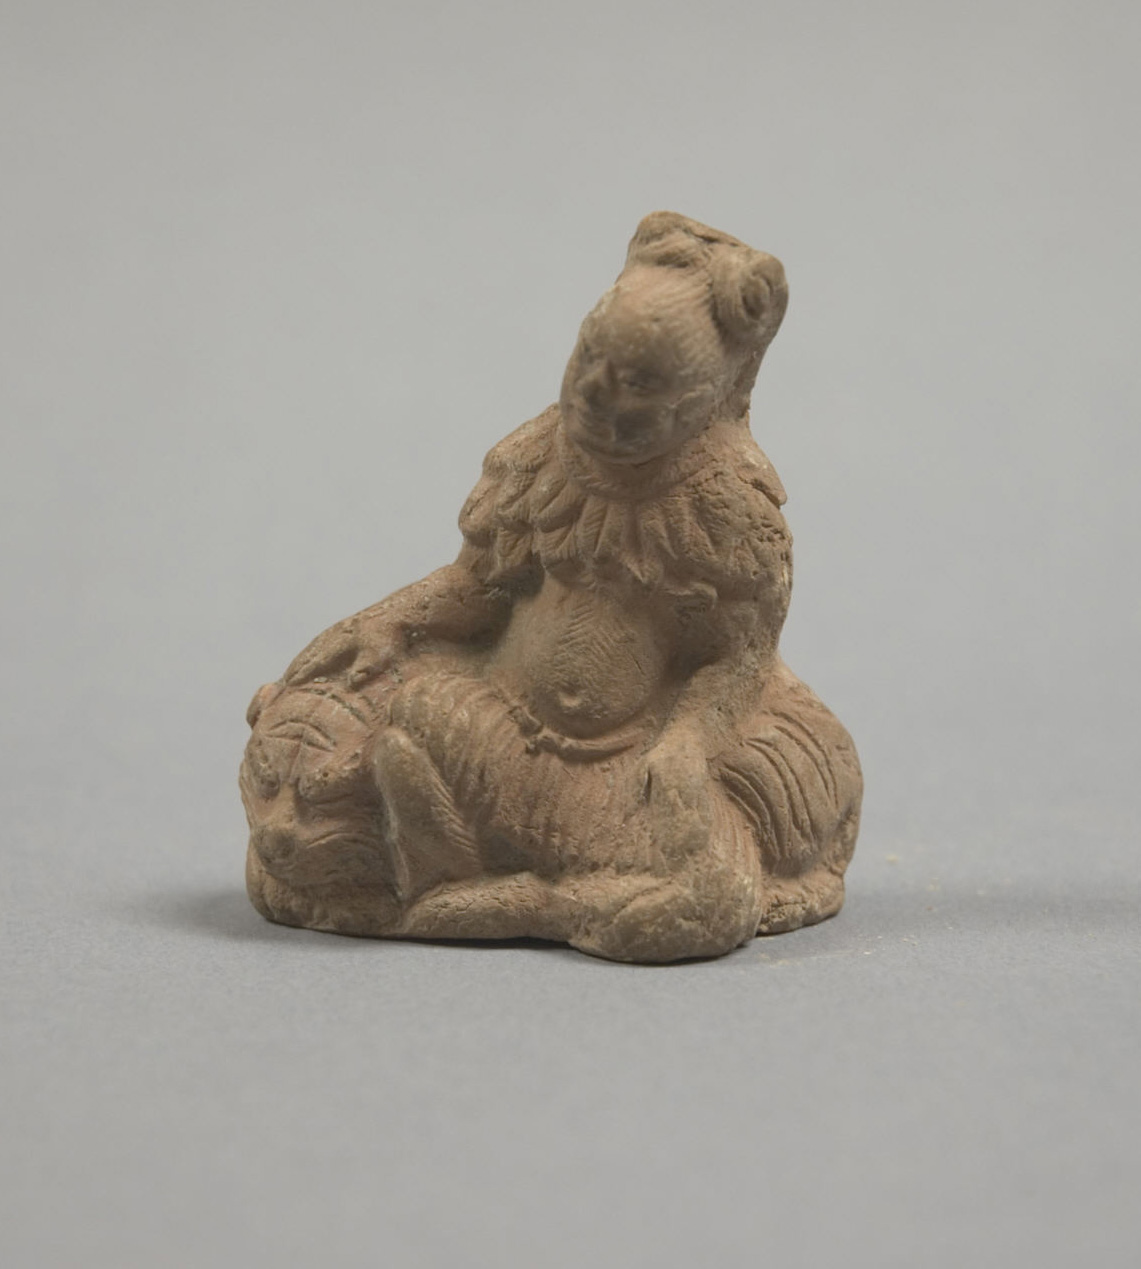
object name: figurine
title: Figure of Luohan and Tiger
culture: chinese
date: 960-1279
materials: pottery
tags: men